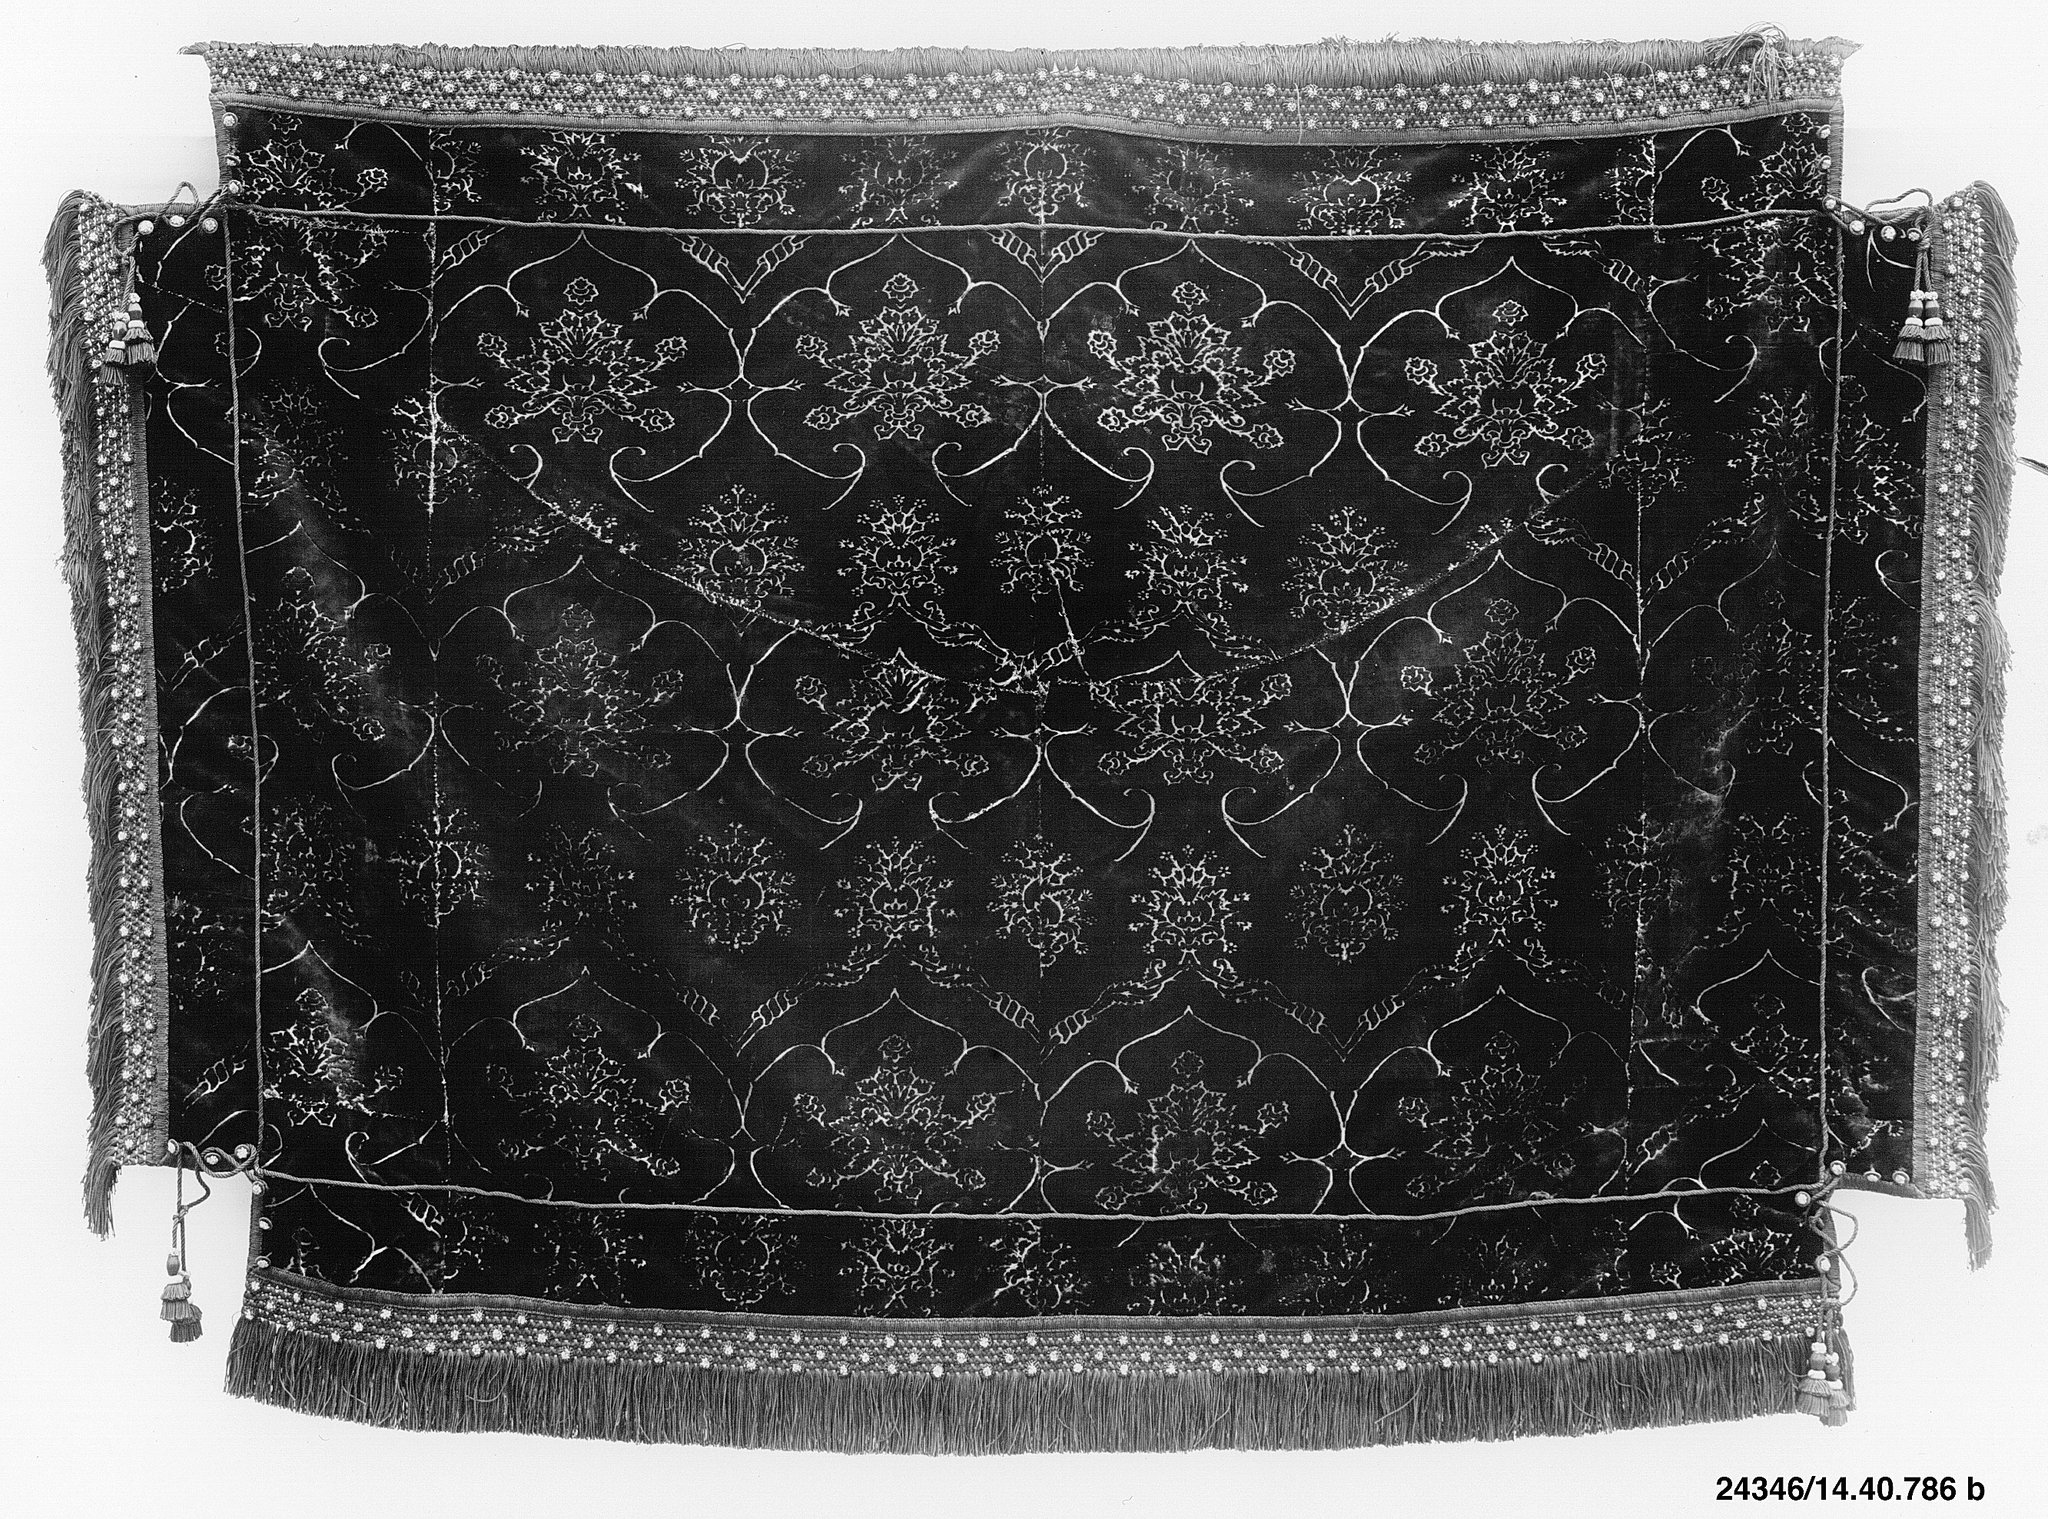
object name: table cover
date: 1401-1500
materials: silk